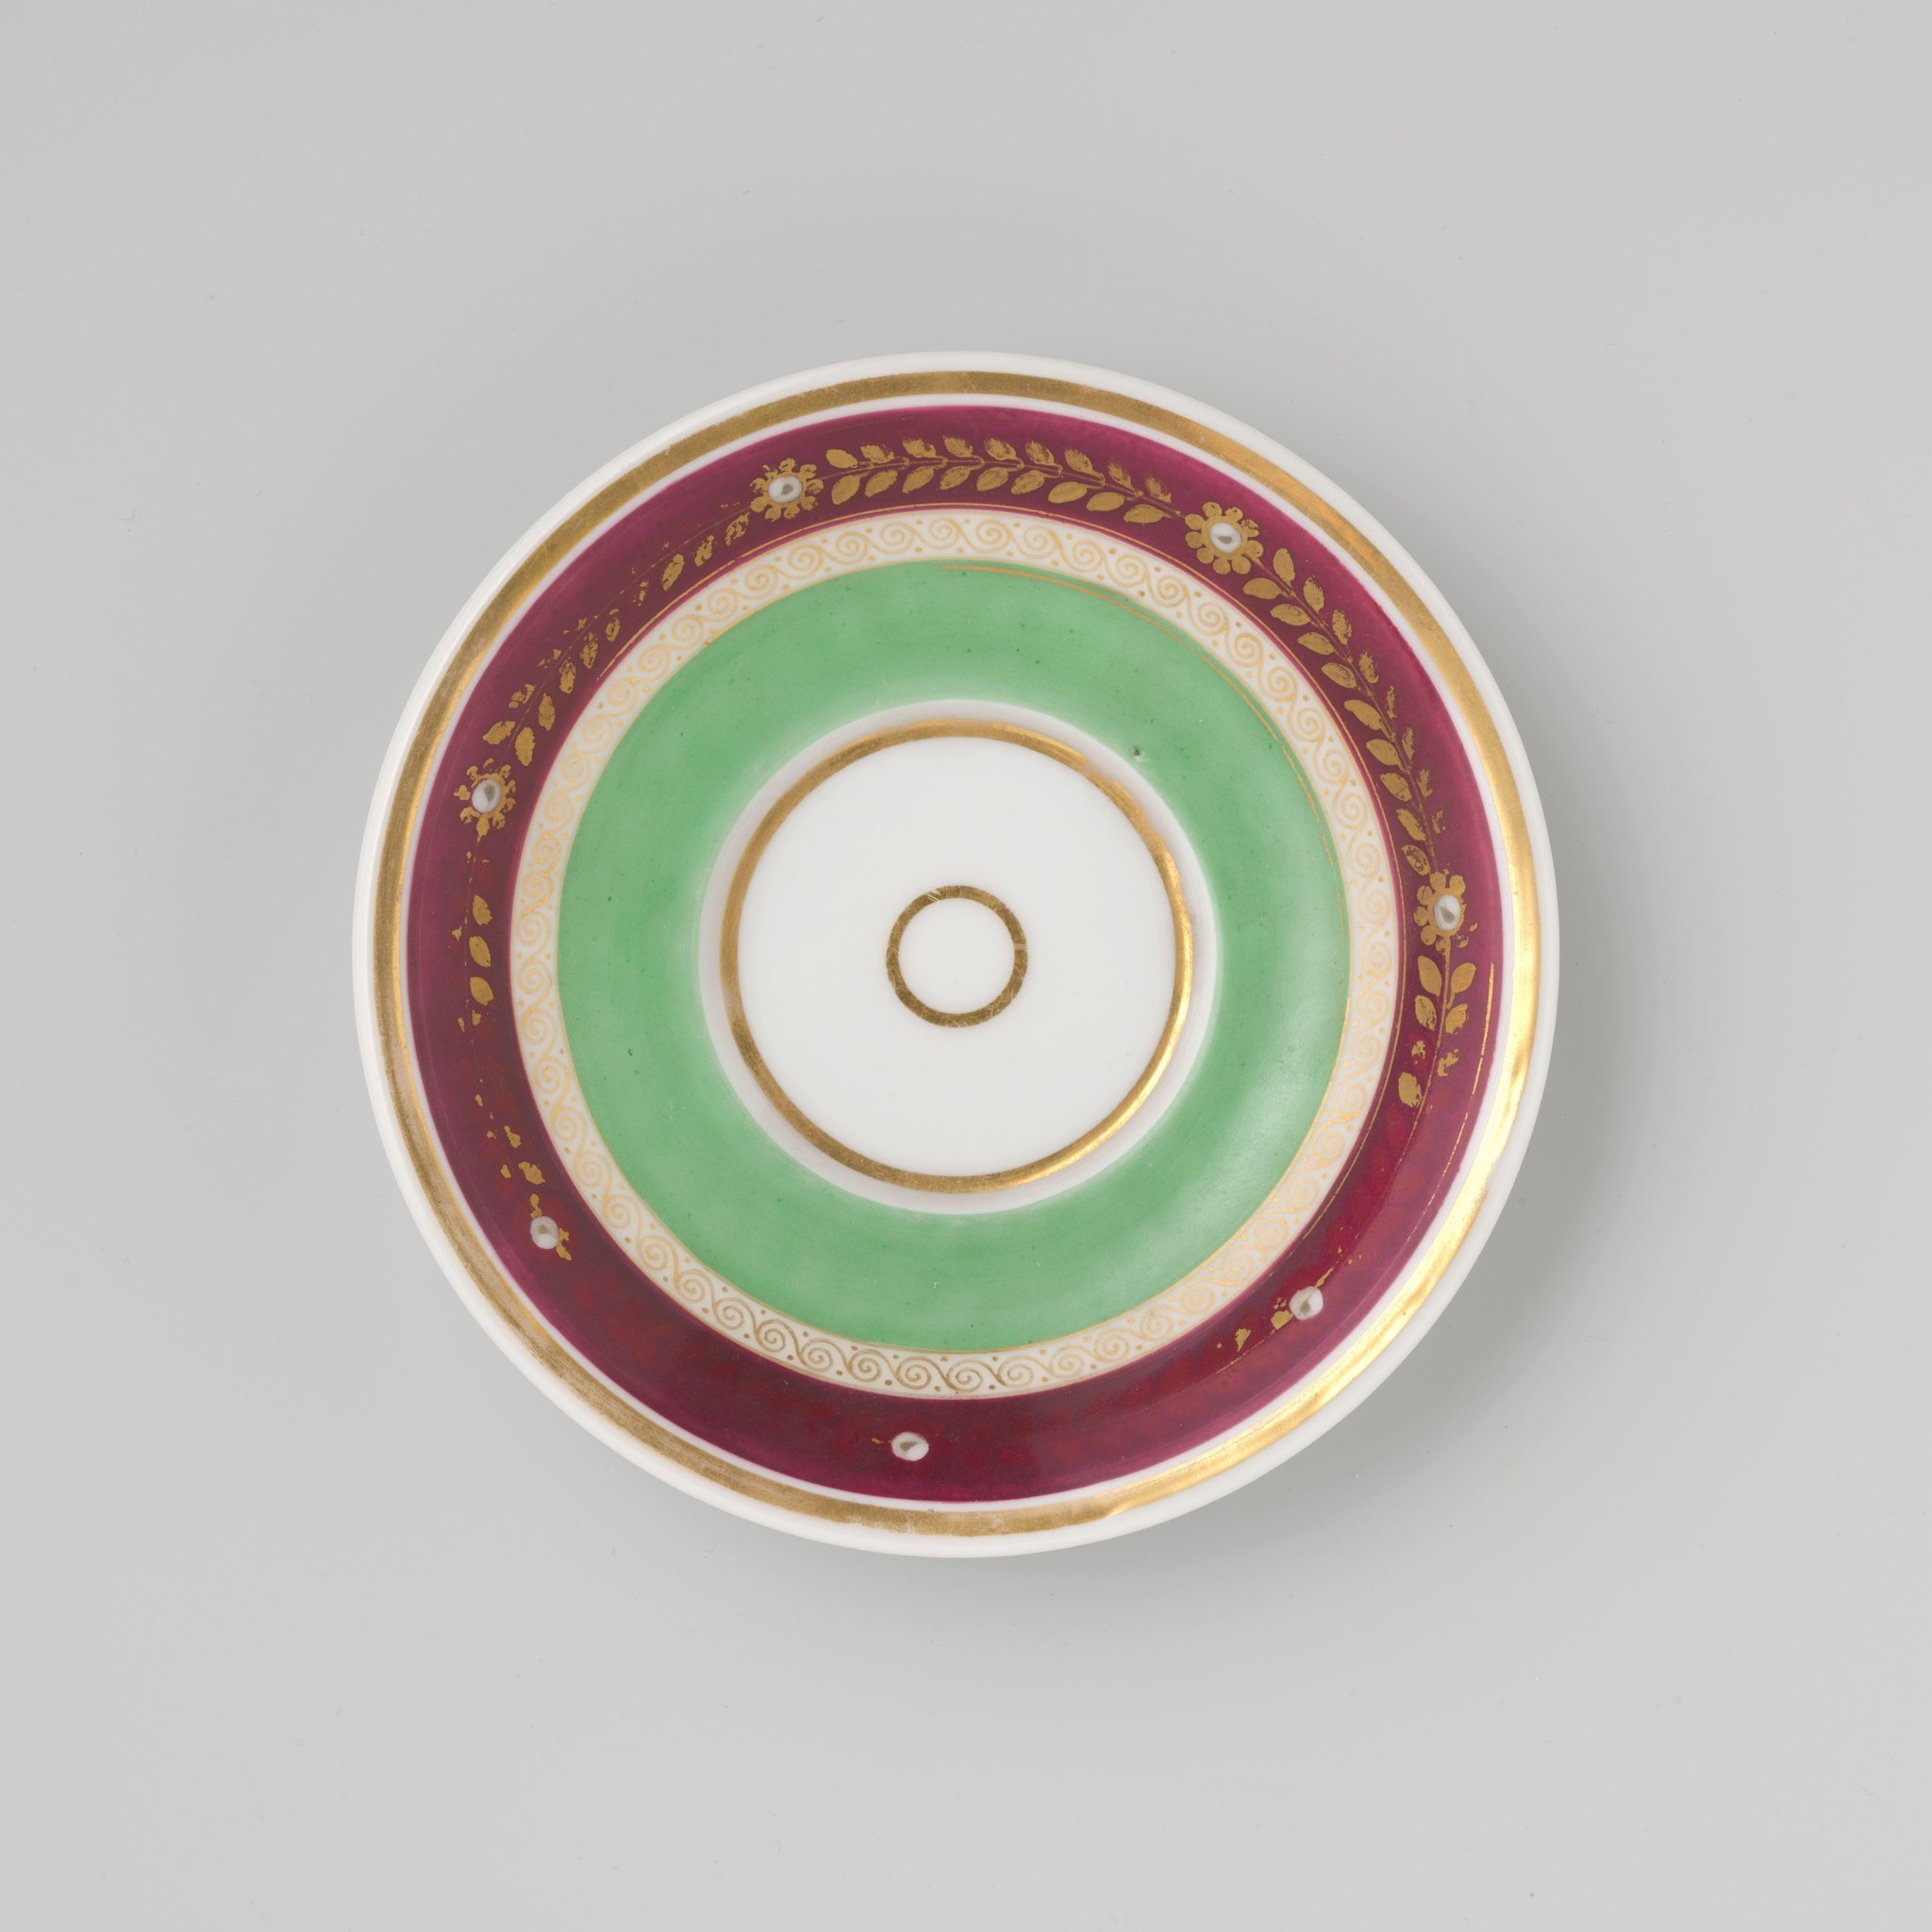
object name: platter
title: Saucer with ornamental borders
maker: Anonymous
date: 1800-1820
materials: glaze, gold, paint, porcelain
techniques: firing, forming, gilding, turning, vitrification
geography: europe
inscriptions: mark: ‘6 of 9’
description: Schotel van porselein, beschilderd op het glazuur in rood, groen en goud. Op het plat een dubbel gouden medaillon. De wand is verdeeld in drie banden: de onderste groen, de middelste met gouden krulwerk en de bovenste met een doorlopende, gouden bloemrank tegen een rode achtergrond. Gouden rand. Gemerkt op de onderzijde met 6 of 9.